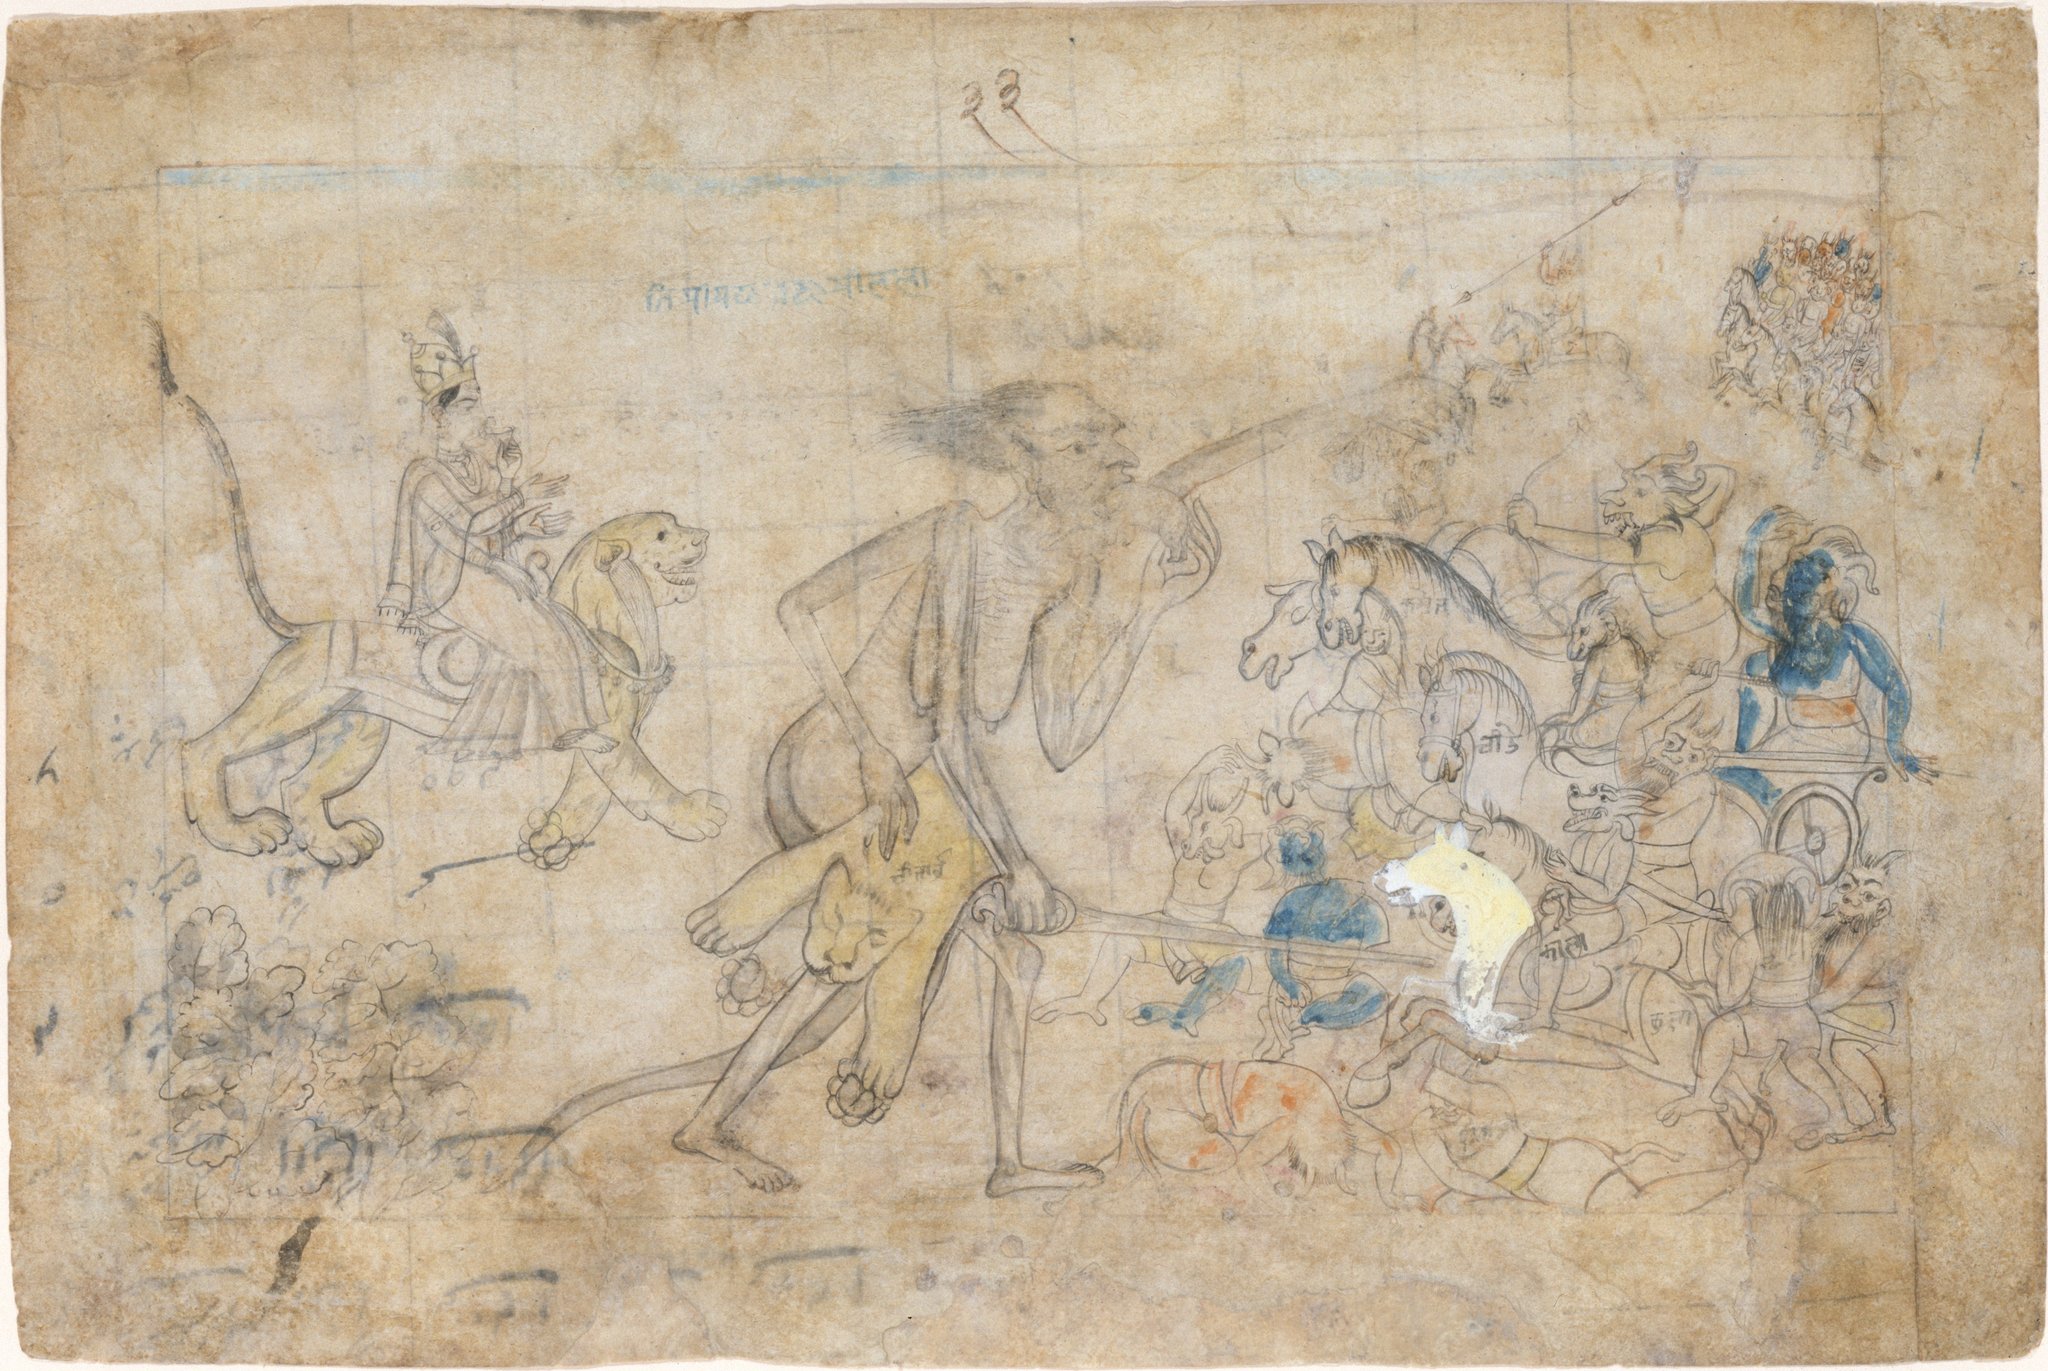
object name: folio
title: Durga and Kali Approach the Gathered Armies of Chanda and Munda: Scene from the Devi Mahatmya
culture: indian, guler, himachal pradesh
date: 1780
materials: ink, paper, watercolor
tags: swords,horses,lions,demons,goddess,durga